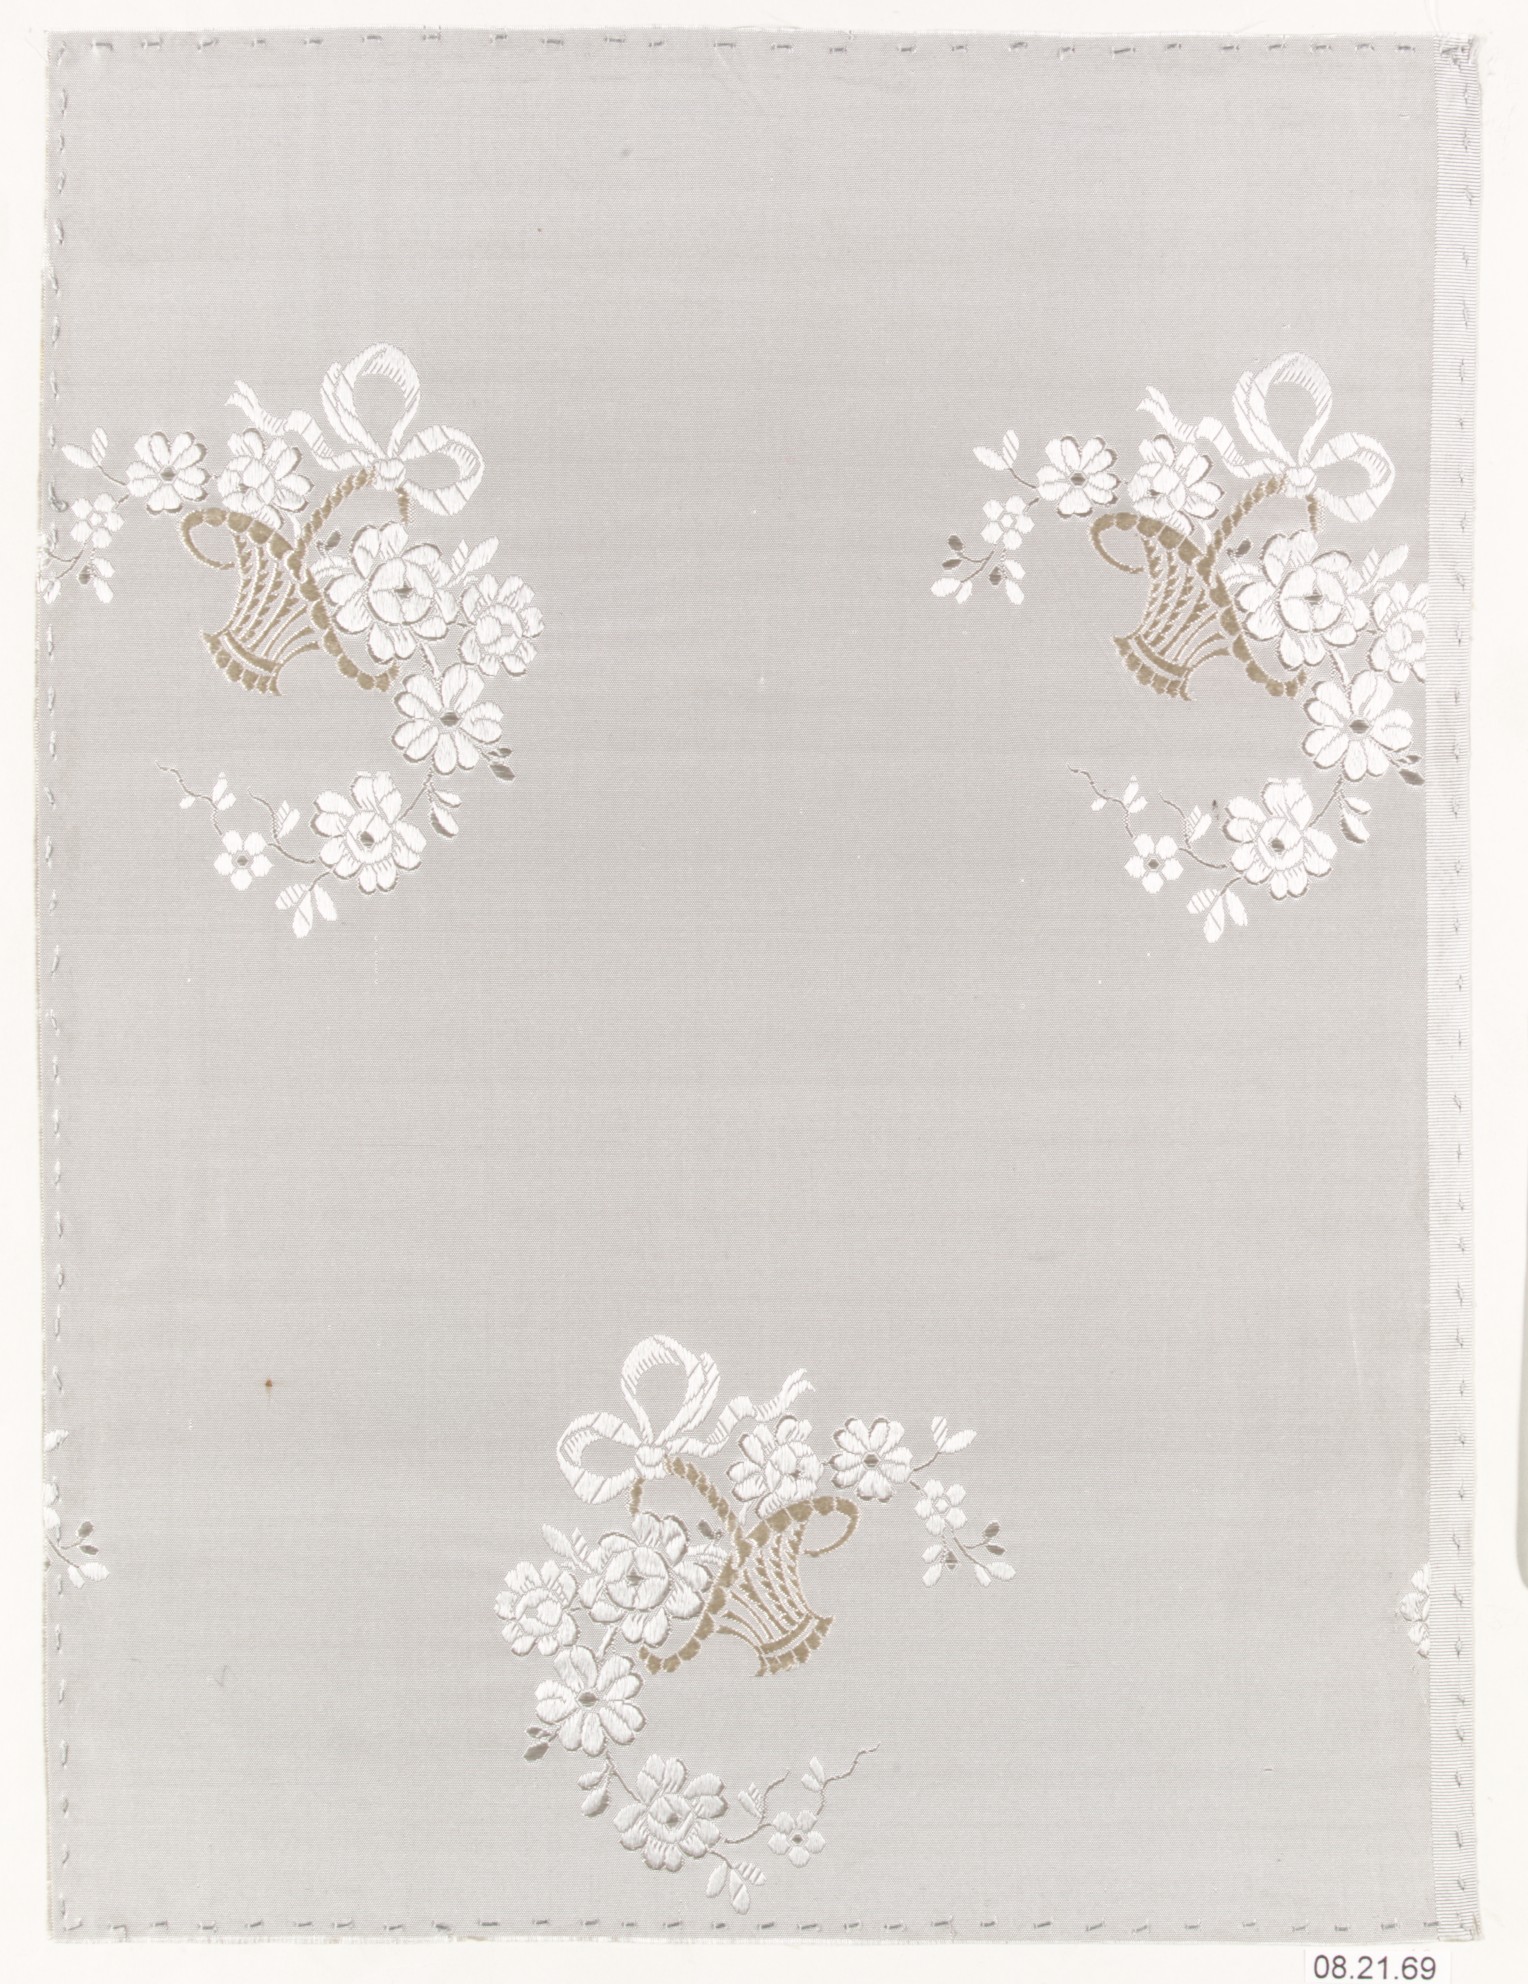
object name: textile sample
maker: Anonymous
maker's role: designer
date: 1900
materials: silk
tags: flowers